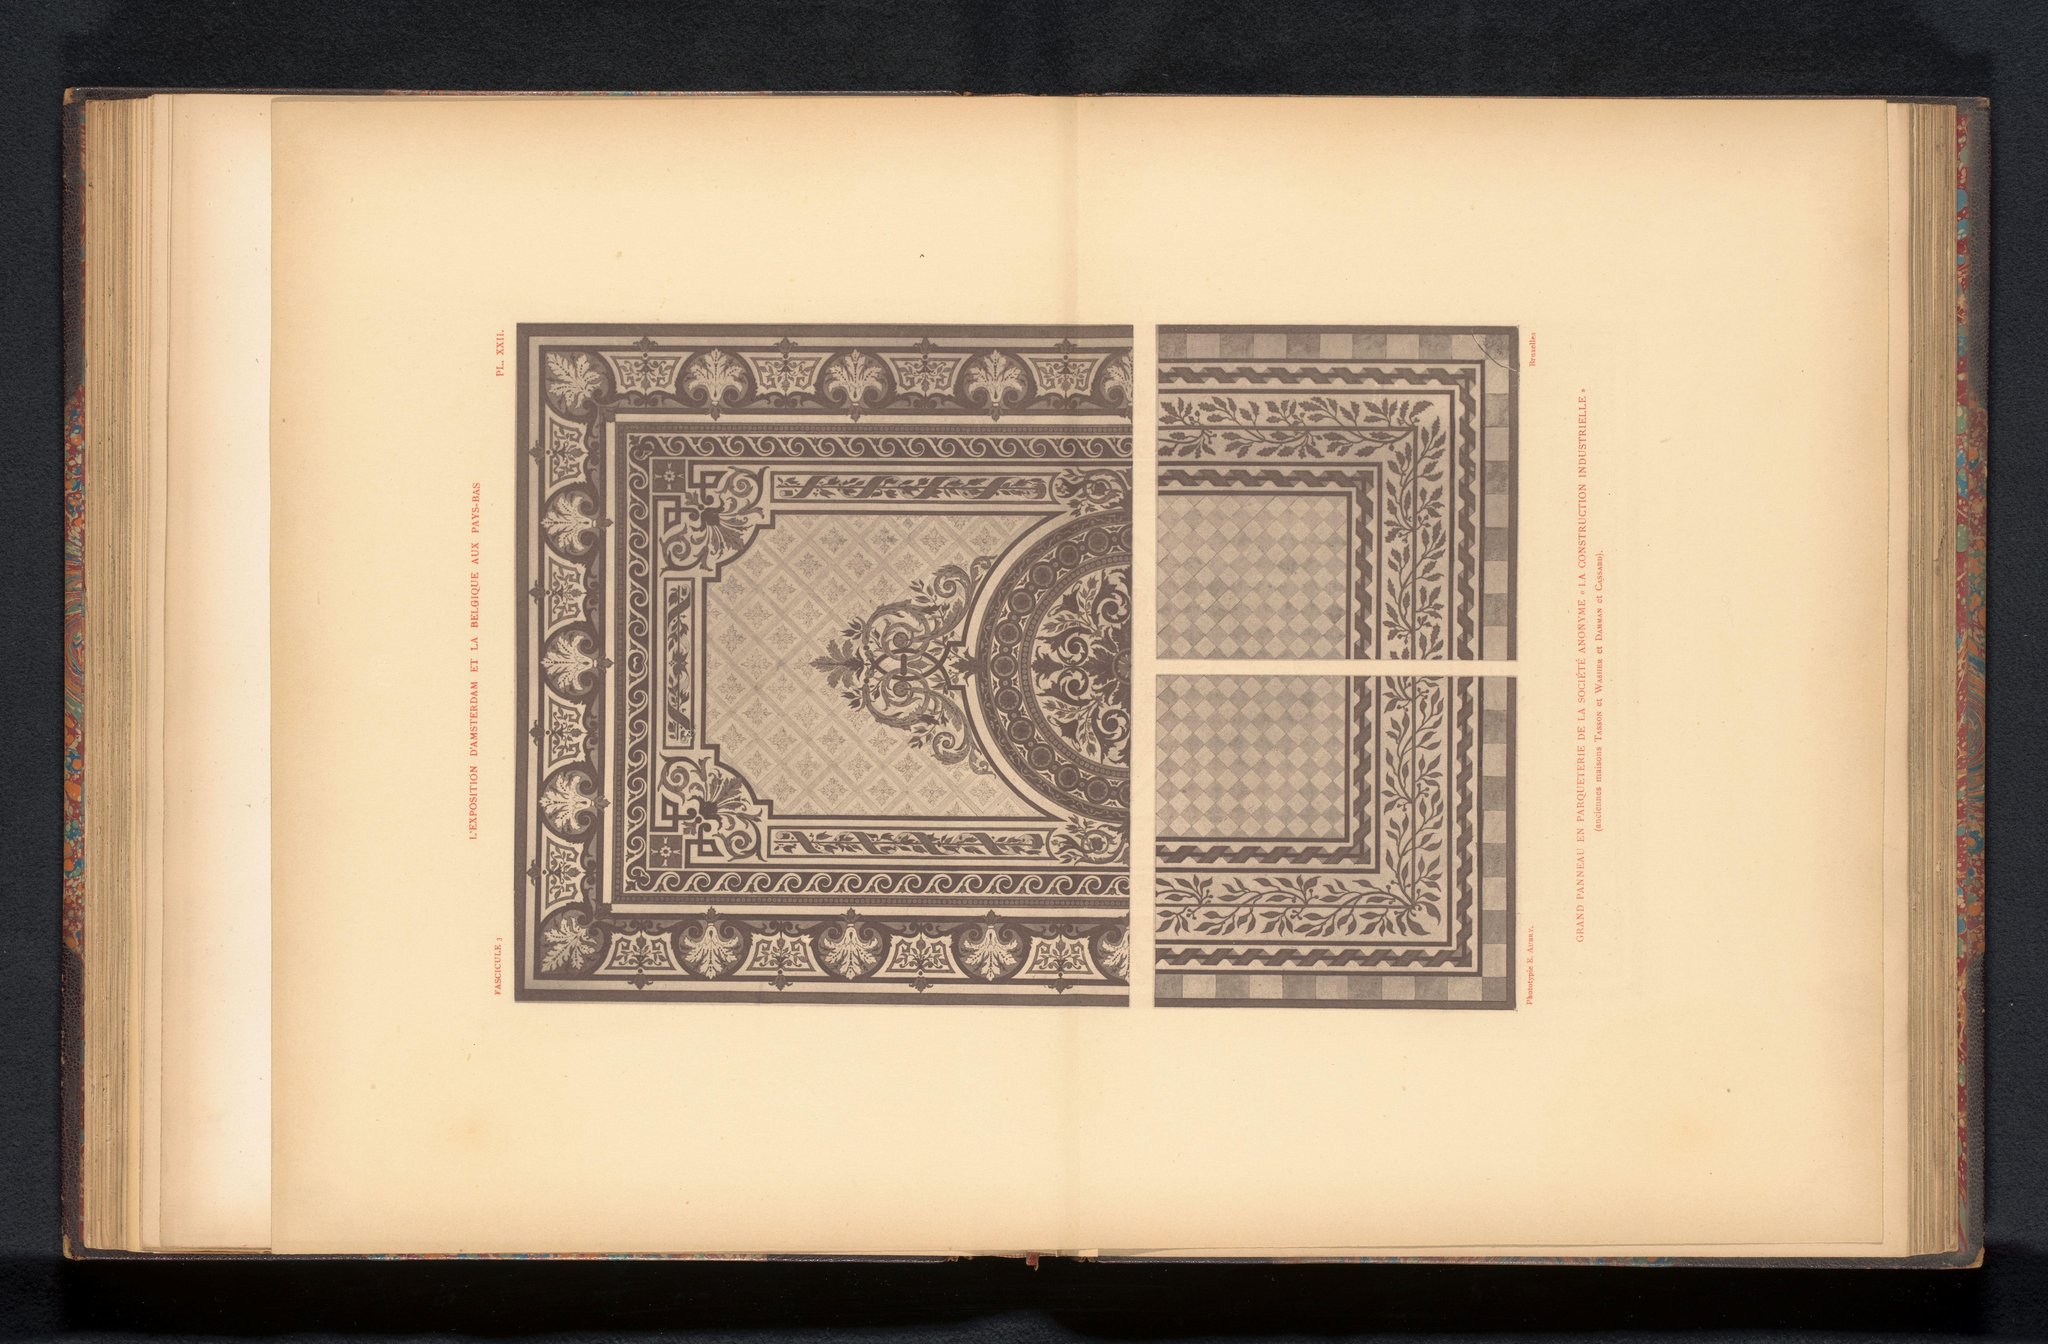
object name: page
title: Drie opnamen van panelen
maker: emile aubry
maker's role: print maker, printer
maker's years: 1829-1900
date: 1878-1883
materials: paper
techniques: photograph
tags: panelling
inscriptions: inscription: ‘Fascicule 3/ PL. XXII’